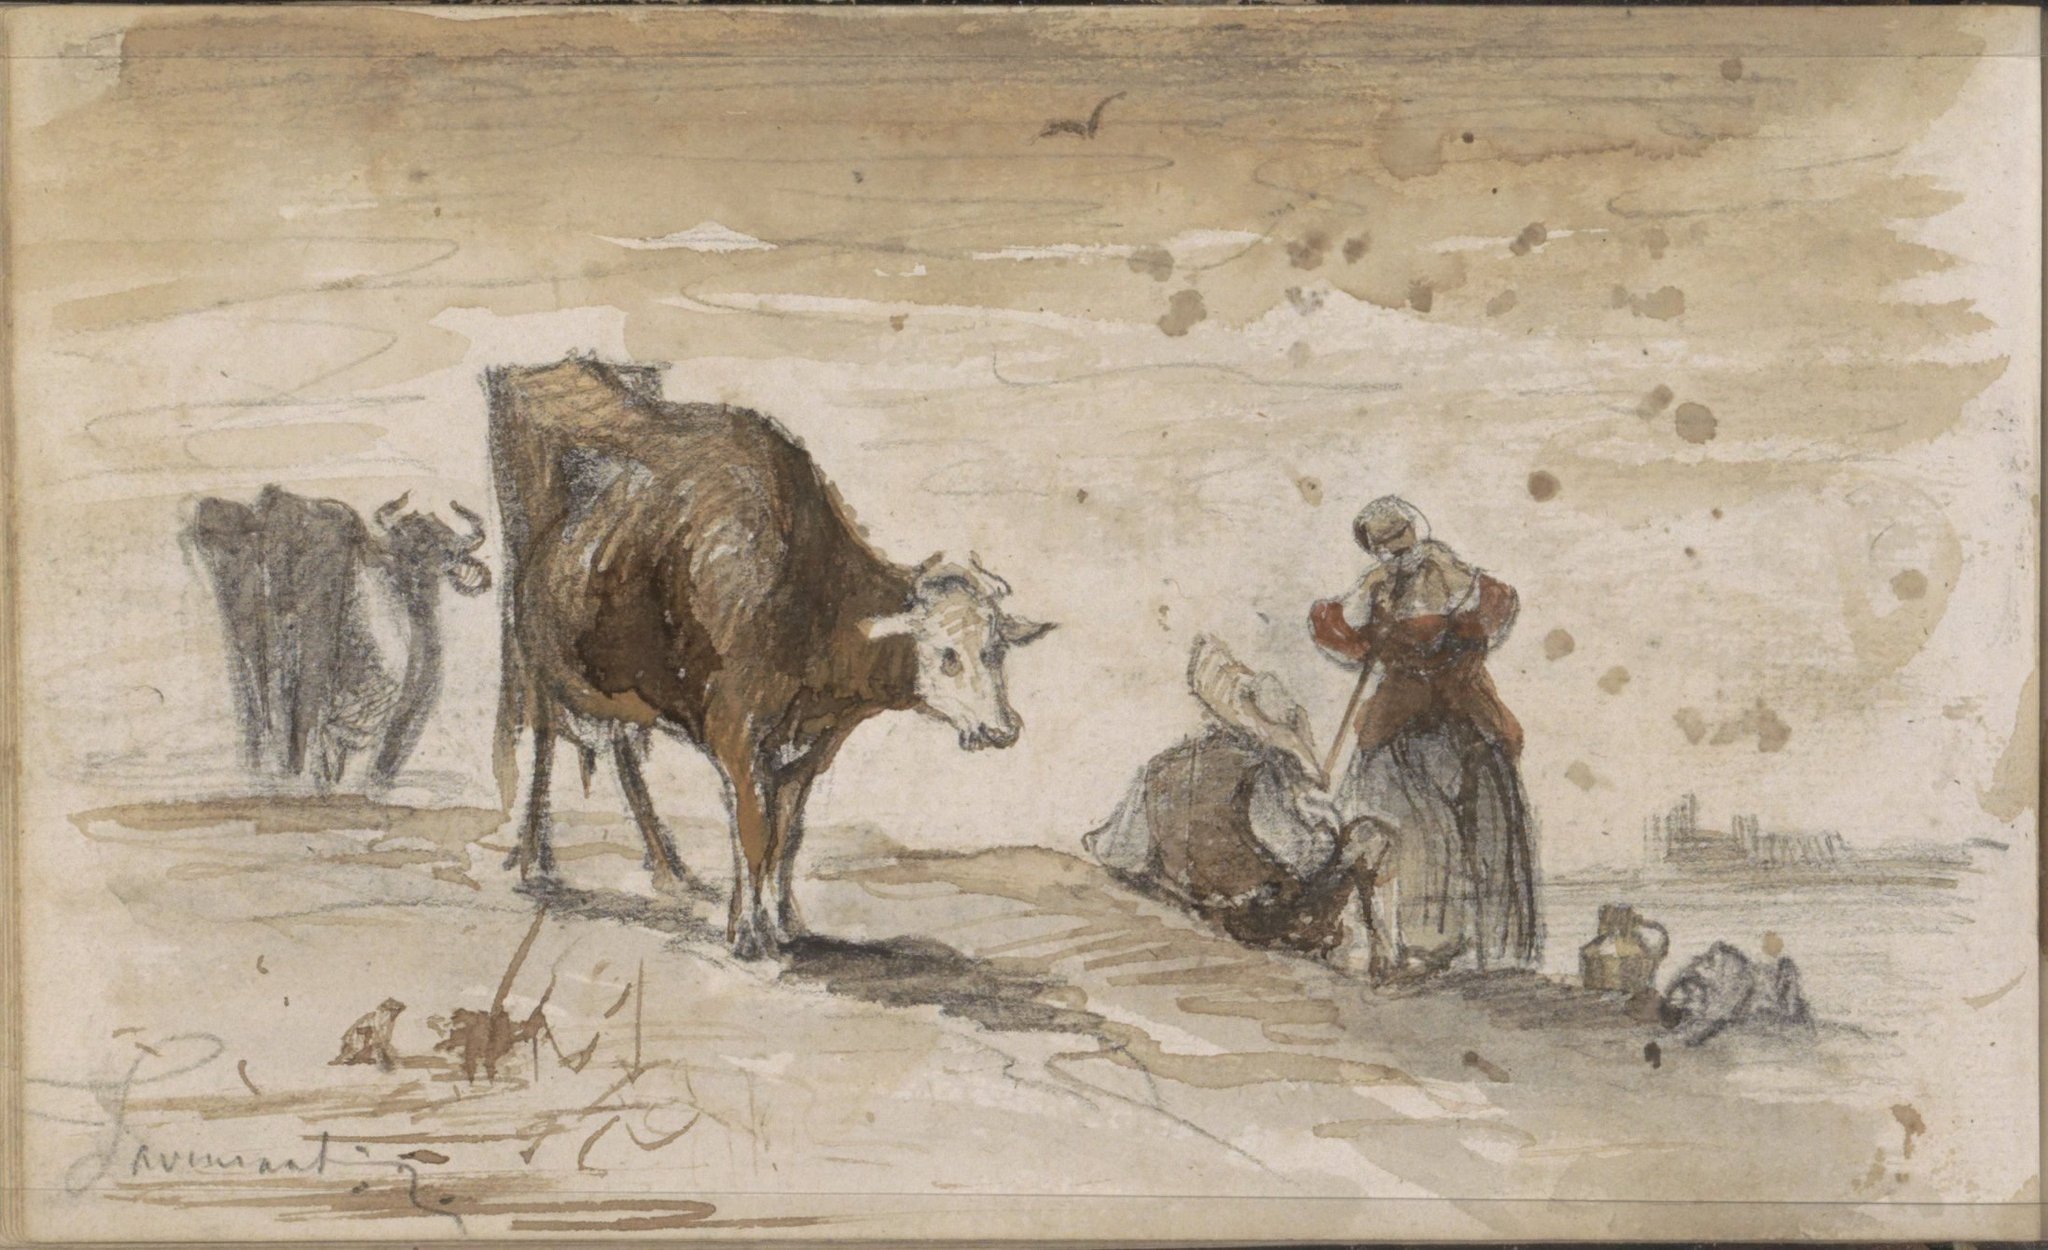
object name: sketchbook leaf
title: Koeien en figuren op een heuvel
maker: johannes tavenraat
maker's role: draughtsman, painter, print maker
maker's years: 1809-1881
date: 1864-1880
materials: ink, paper, pencil, watercolor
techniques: brush, pen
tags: cow, landscapes (+ landscape with figures, staffage), mound, verge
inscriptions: signature: ‘Tavenraat’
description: De man zit in het weiland en de vrouw bespeelt vermoedelijk een instrument. Blad 31 verso uit een schetsboek met 98 bladen.